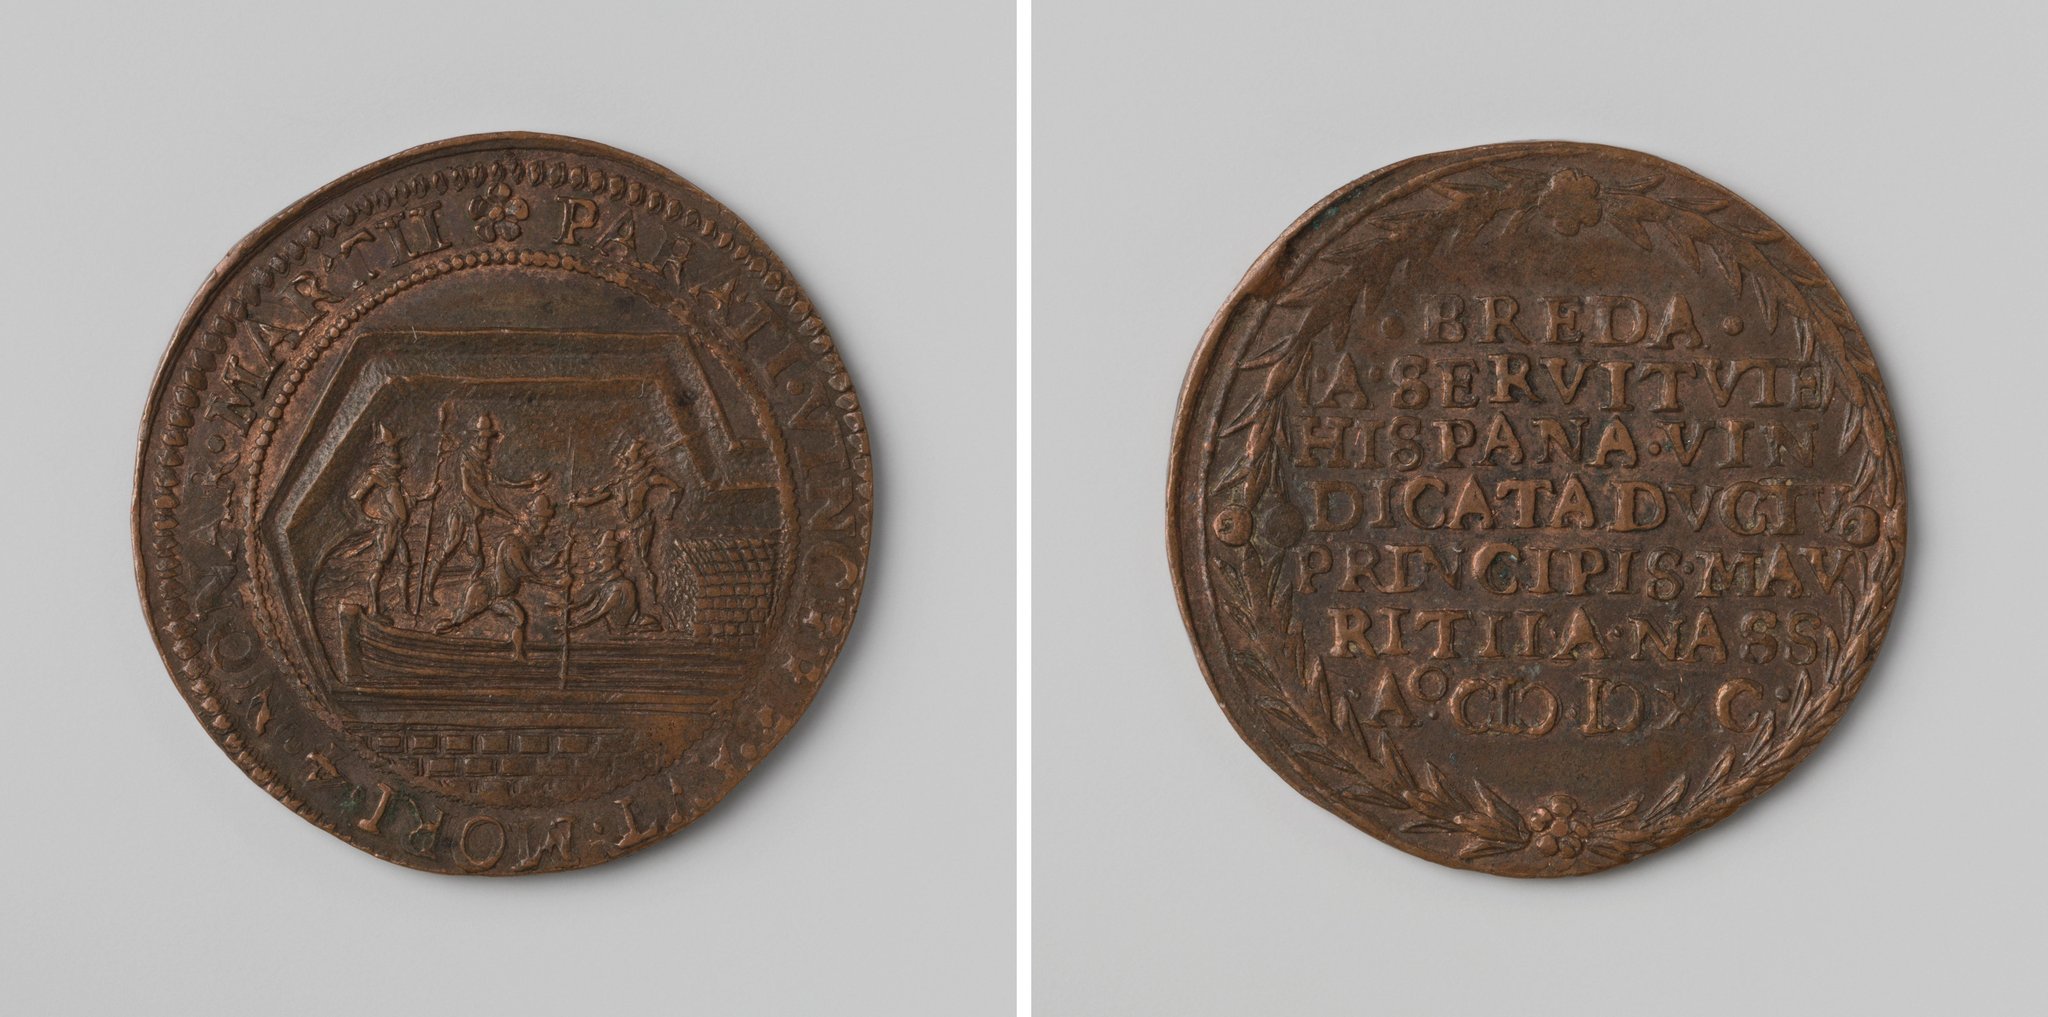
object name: jeton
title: Inname van Breda met behulp van het turfschip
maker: Anonymous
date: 1590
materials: copper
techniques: striking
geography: dordrecht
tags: the hague, maurice (prince of orange)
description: Koperen penning. Voorzijde: uit een met turf geladen schip komen krijgers te voorschijn binnen omschrift. Keerzijde: opschrift binnen lauwerkrans